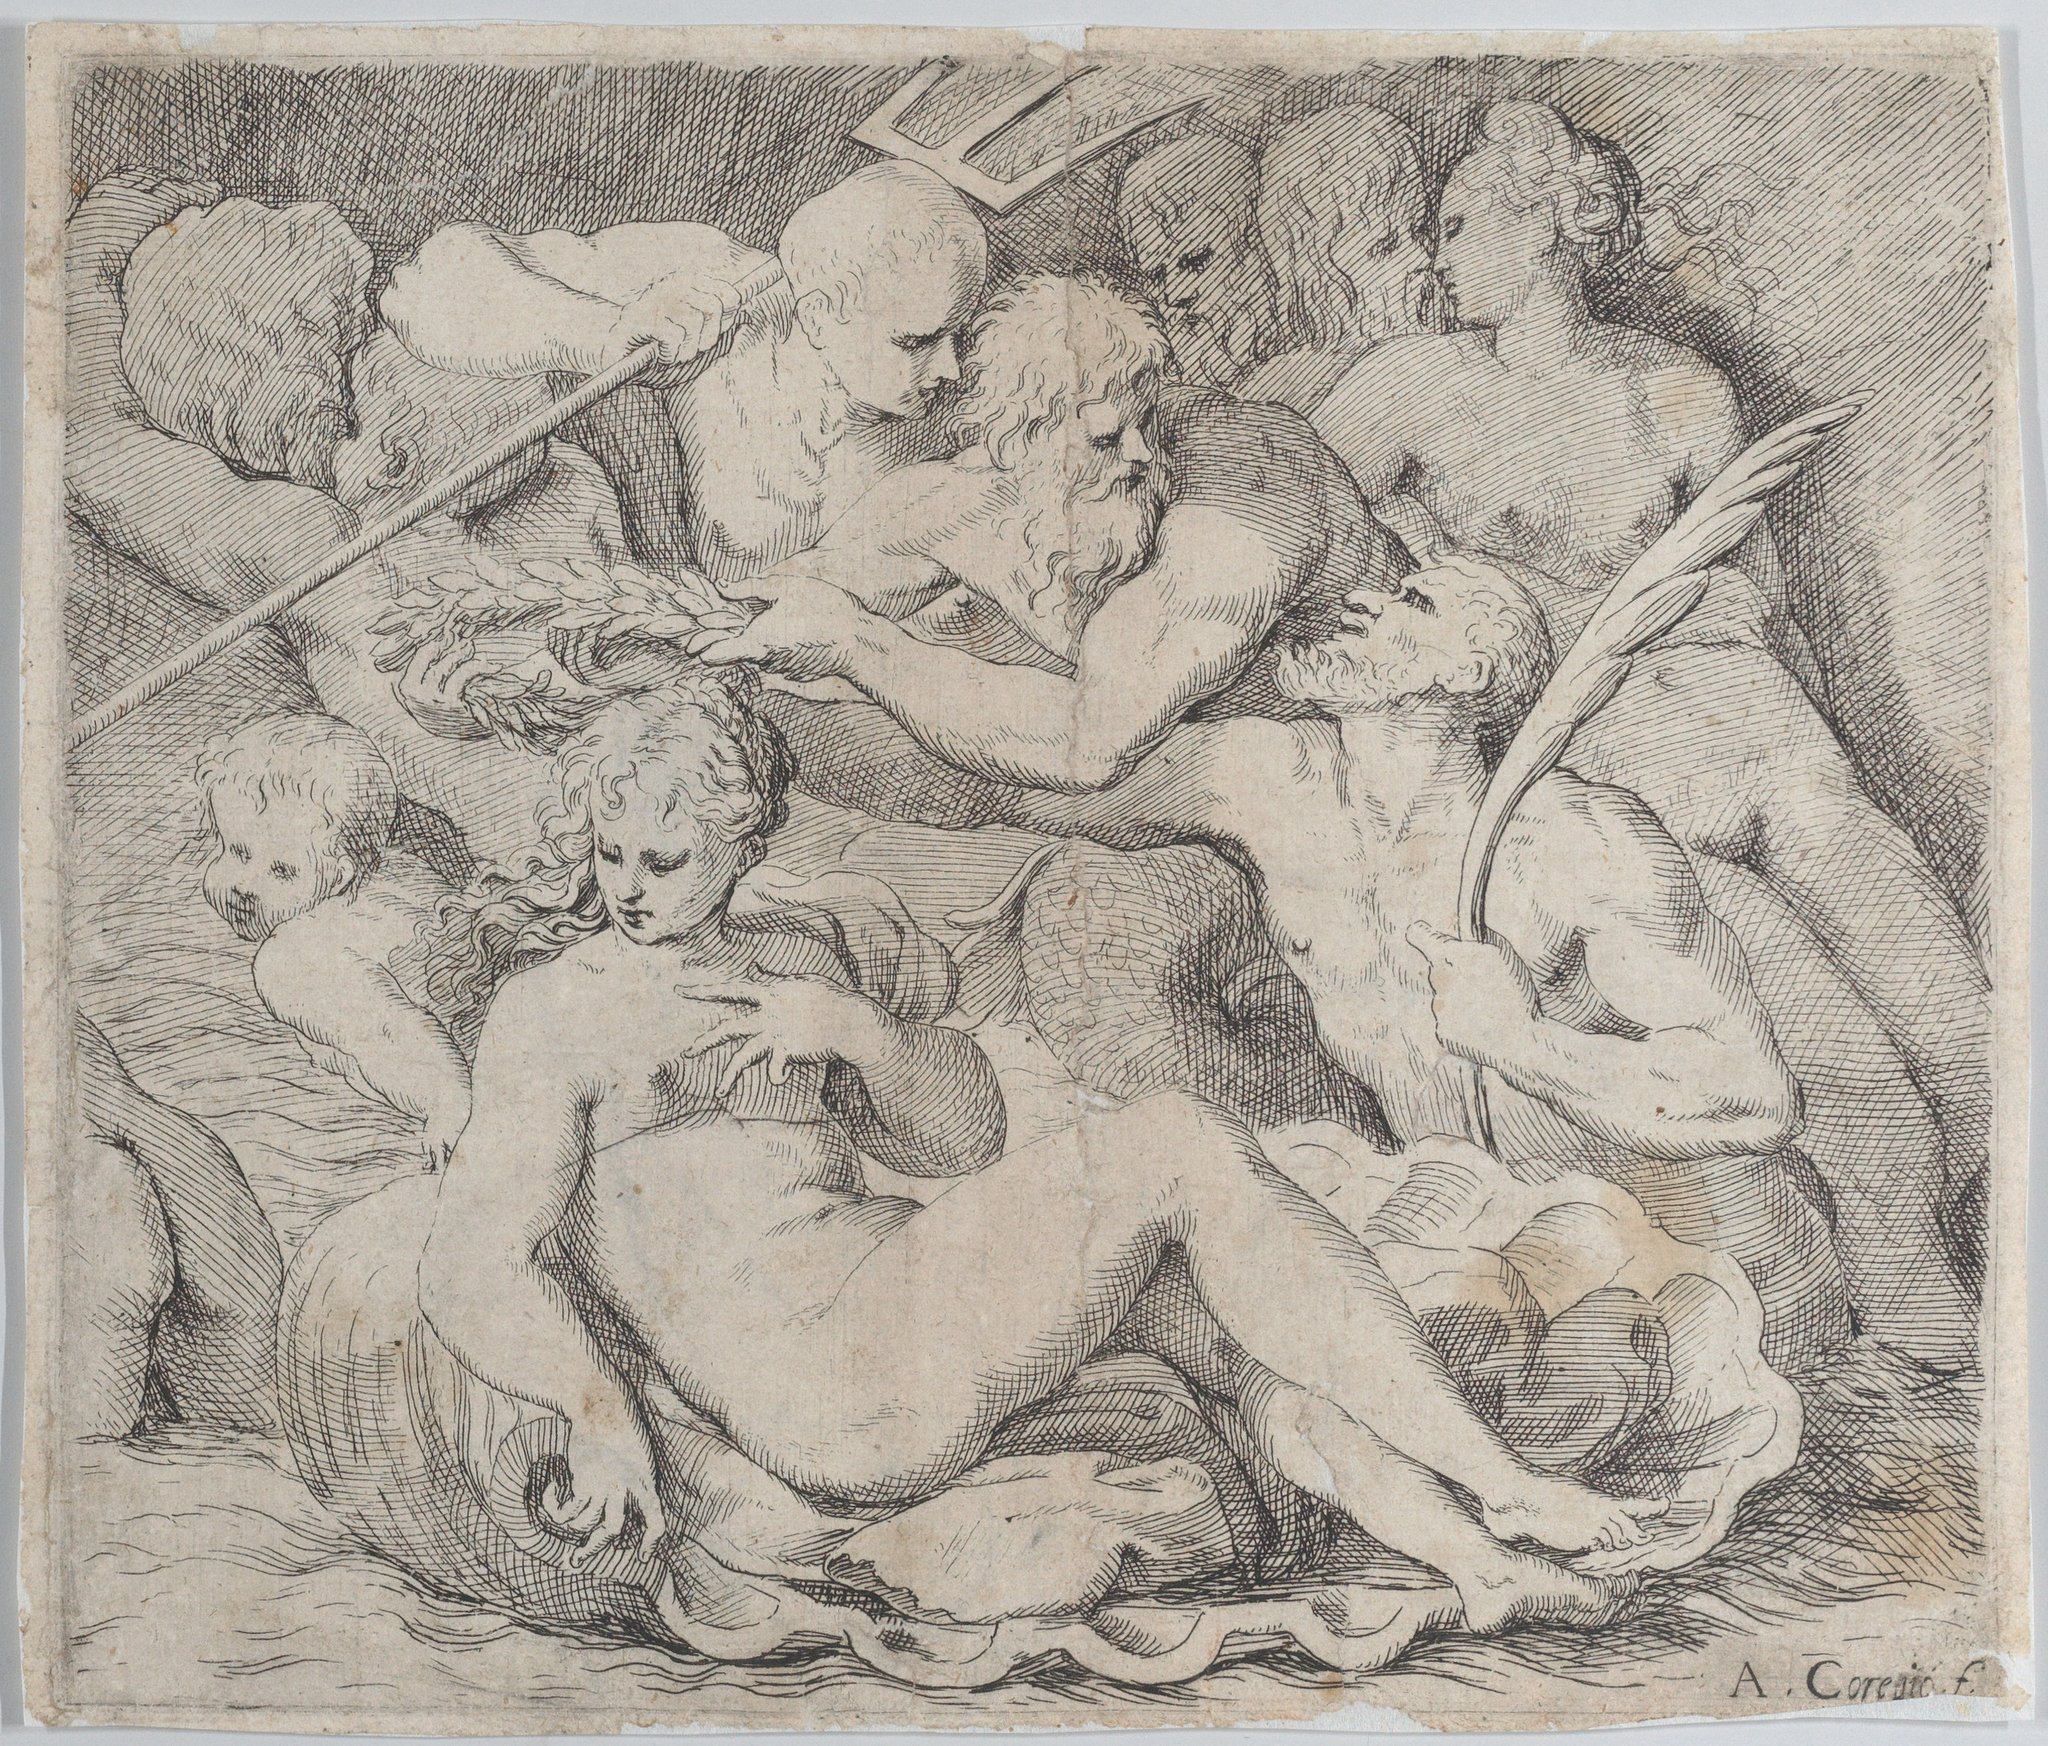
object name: print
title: Venus, recumbent on a shell, surrounded by sea gods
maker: Anonymous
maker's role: artist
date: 1520-1600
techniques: etching